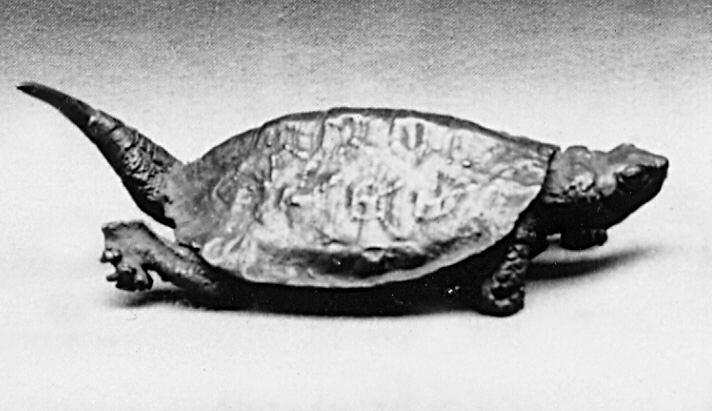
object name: ornament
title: Ornament in the Form of a Tortoise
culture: japanese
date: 1801-1900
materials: bronze